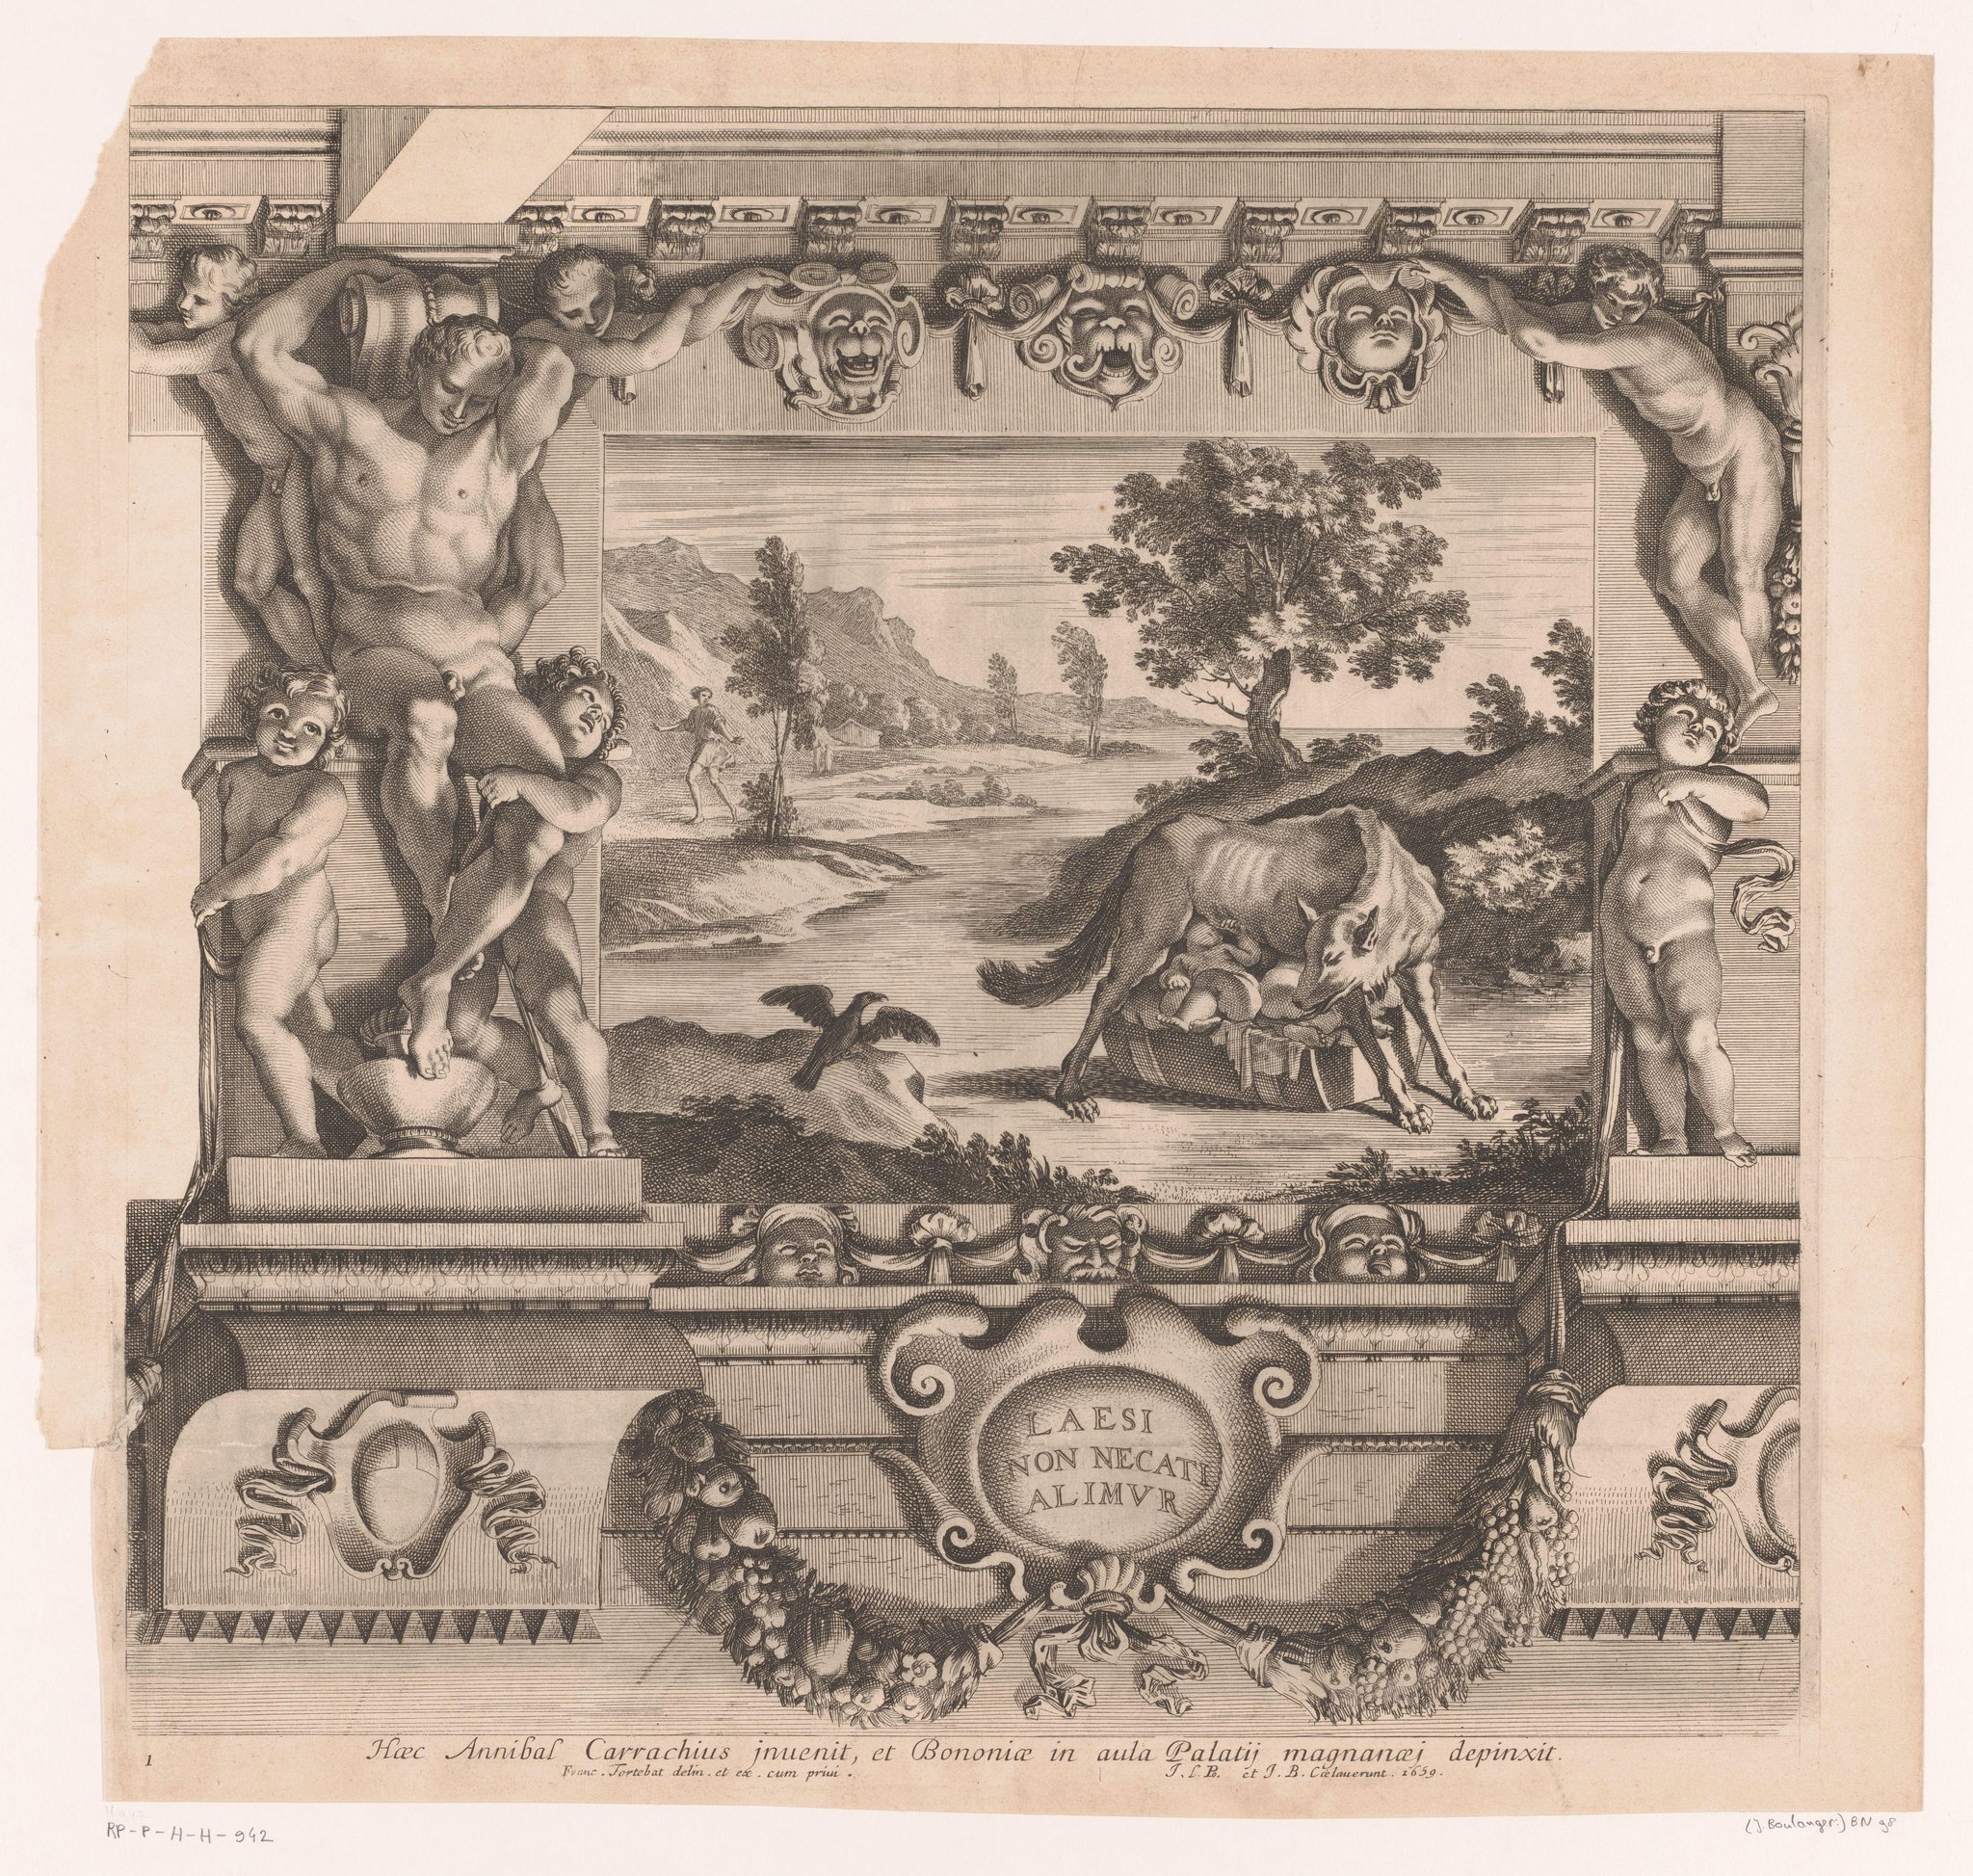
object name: print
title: Romulus en Remus bij de wolvin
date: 1659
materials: paper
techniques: engraving, etching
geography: bologna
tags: romulus and remus are washed ashore and suckled by a she-wolf; 'lupa romana'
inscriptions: collector's mark: Lugt 11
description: Maakt deel uit van een 14-delige serie met scènes uit het verhaal van Romulus en Remus naar ontwerpen door de familie Carracci voor het Palazzo Magnani te Bologna. Prent 1 t/m 7 zijn in prent gebracht door Lepautre en Boulanger en prent 8 t/m 14 door De Châtillon.